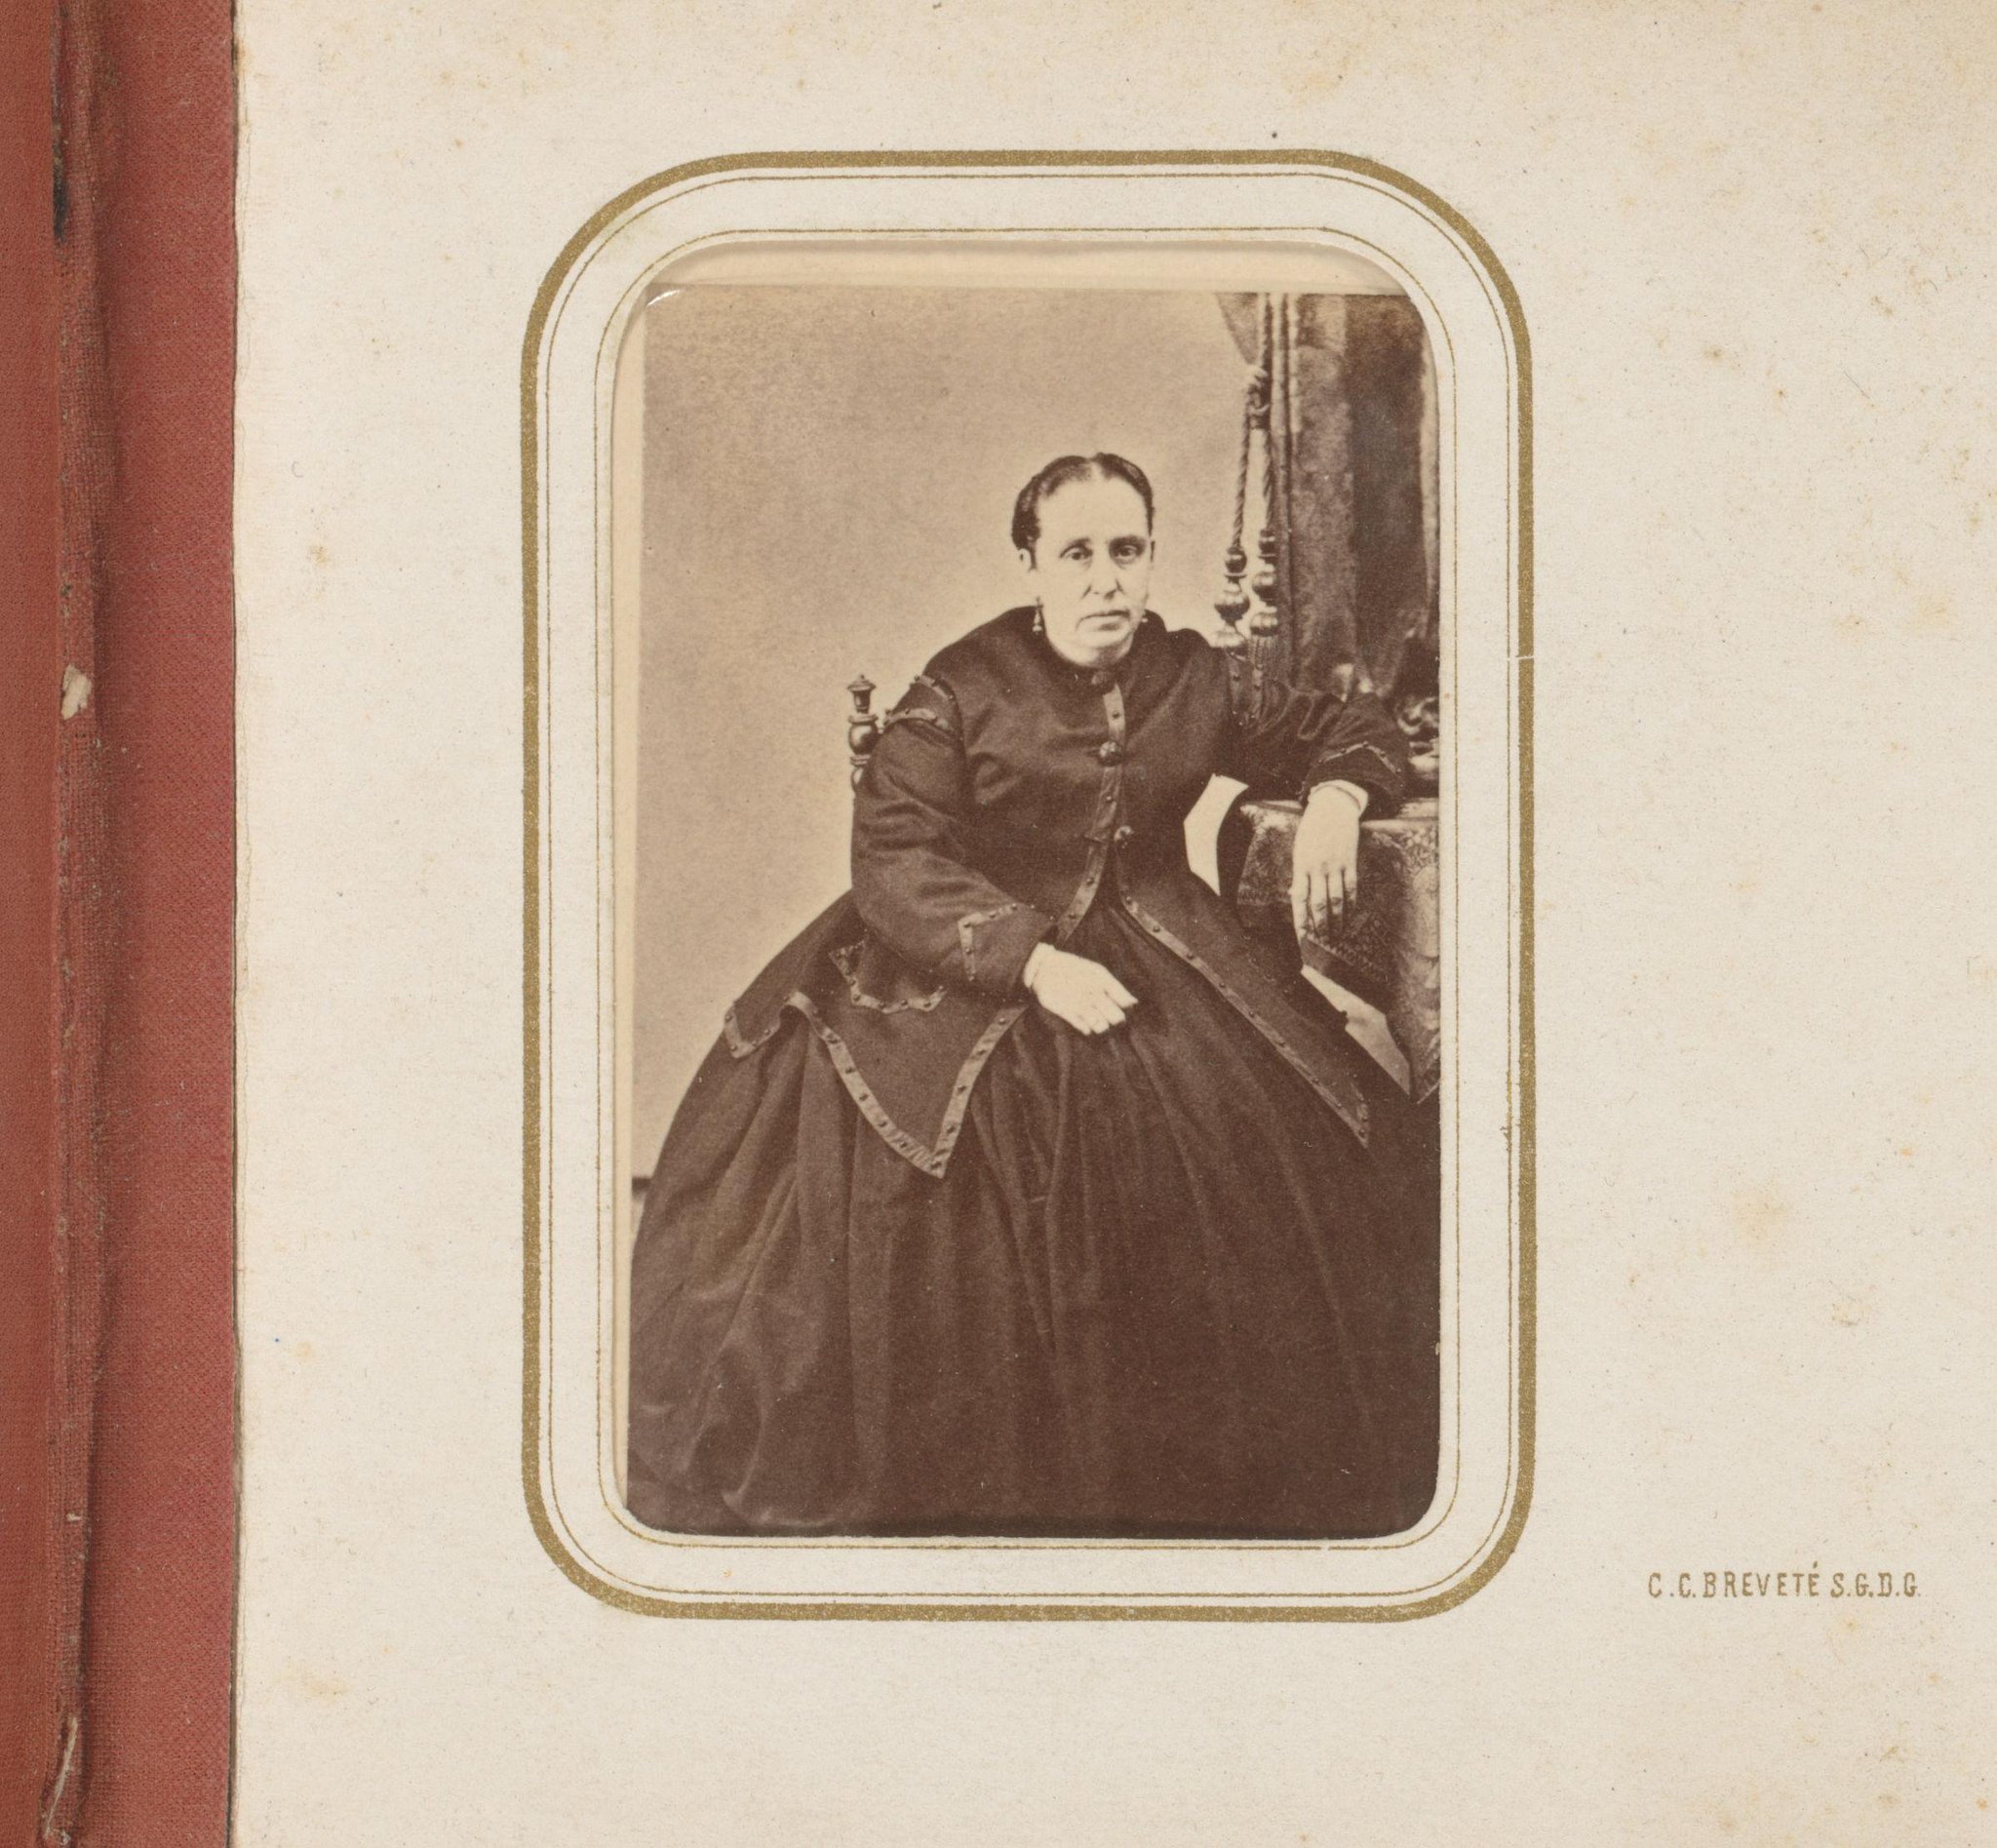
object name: carte de visite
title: Portret van een vrouw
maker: Anonymous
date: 1860-1900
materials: cardboard, photographic support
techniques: albumen print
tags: sitting figure, adult woman, historical persons